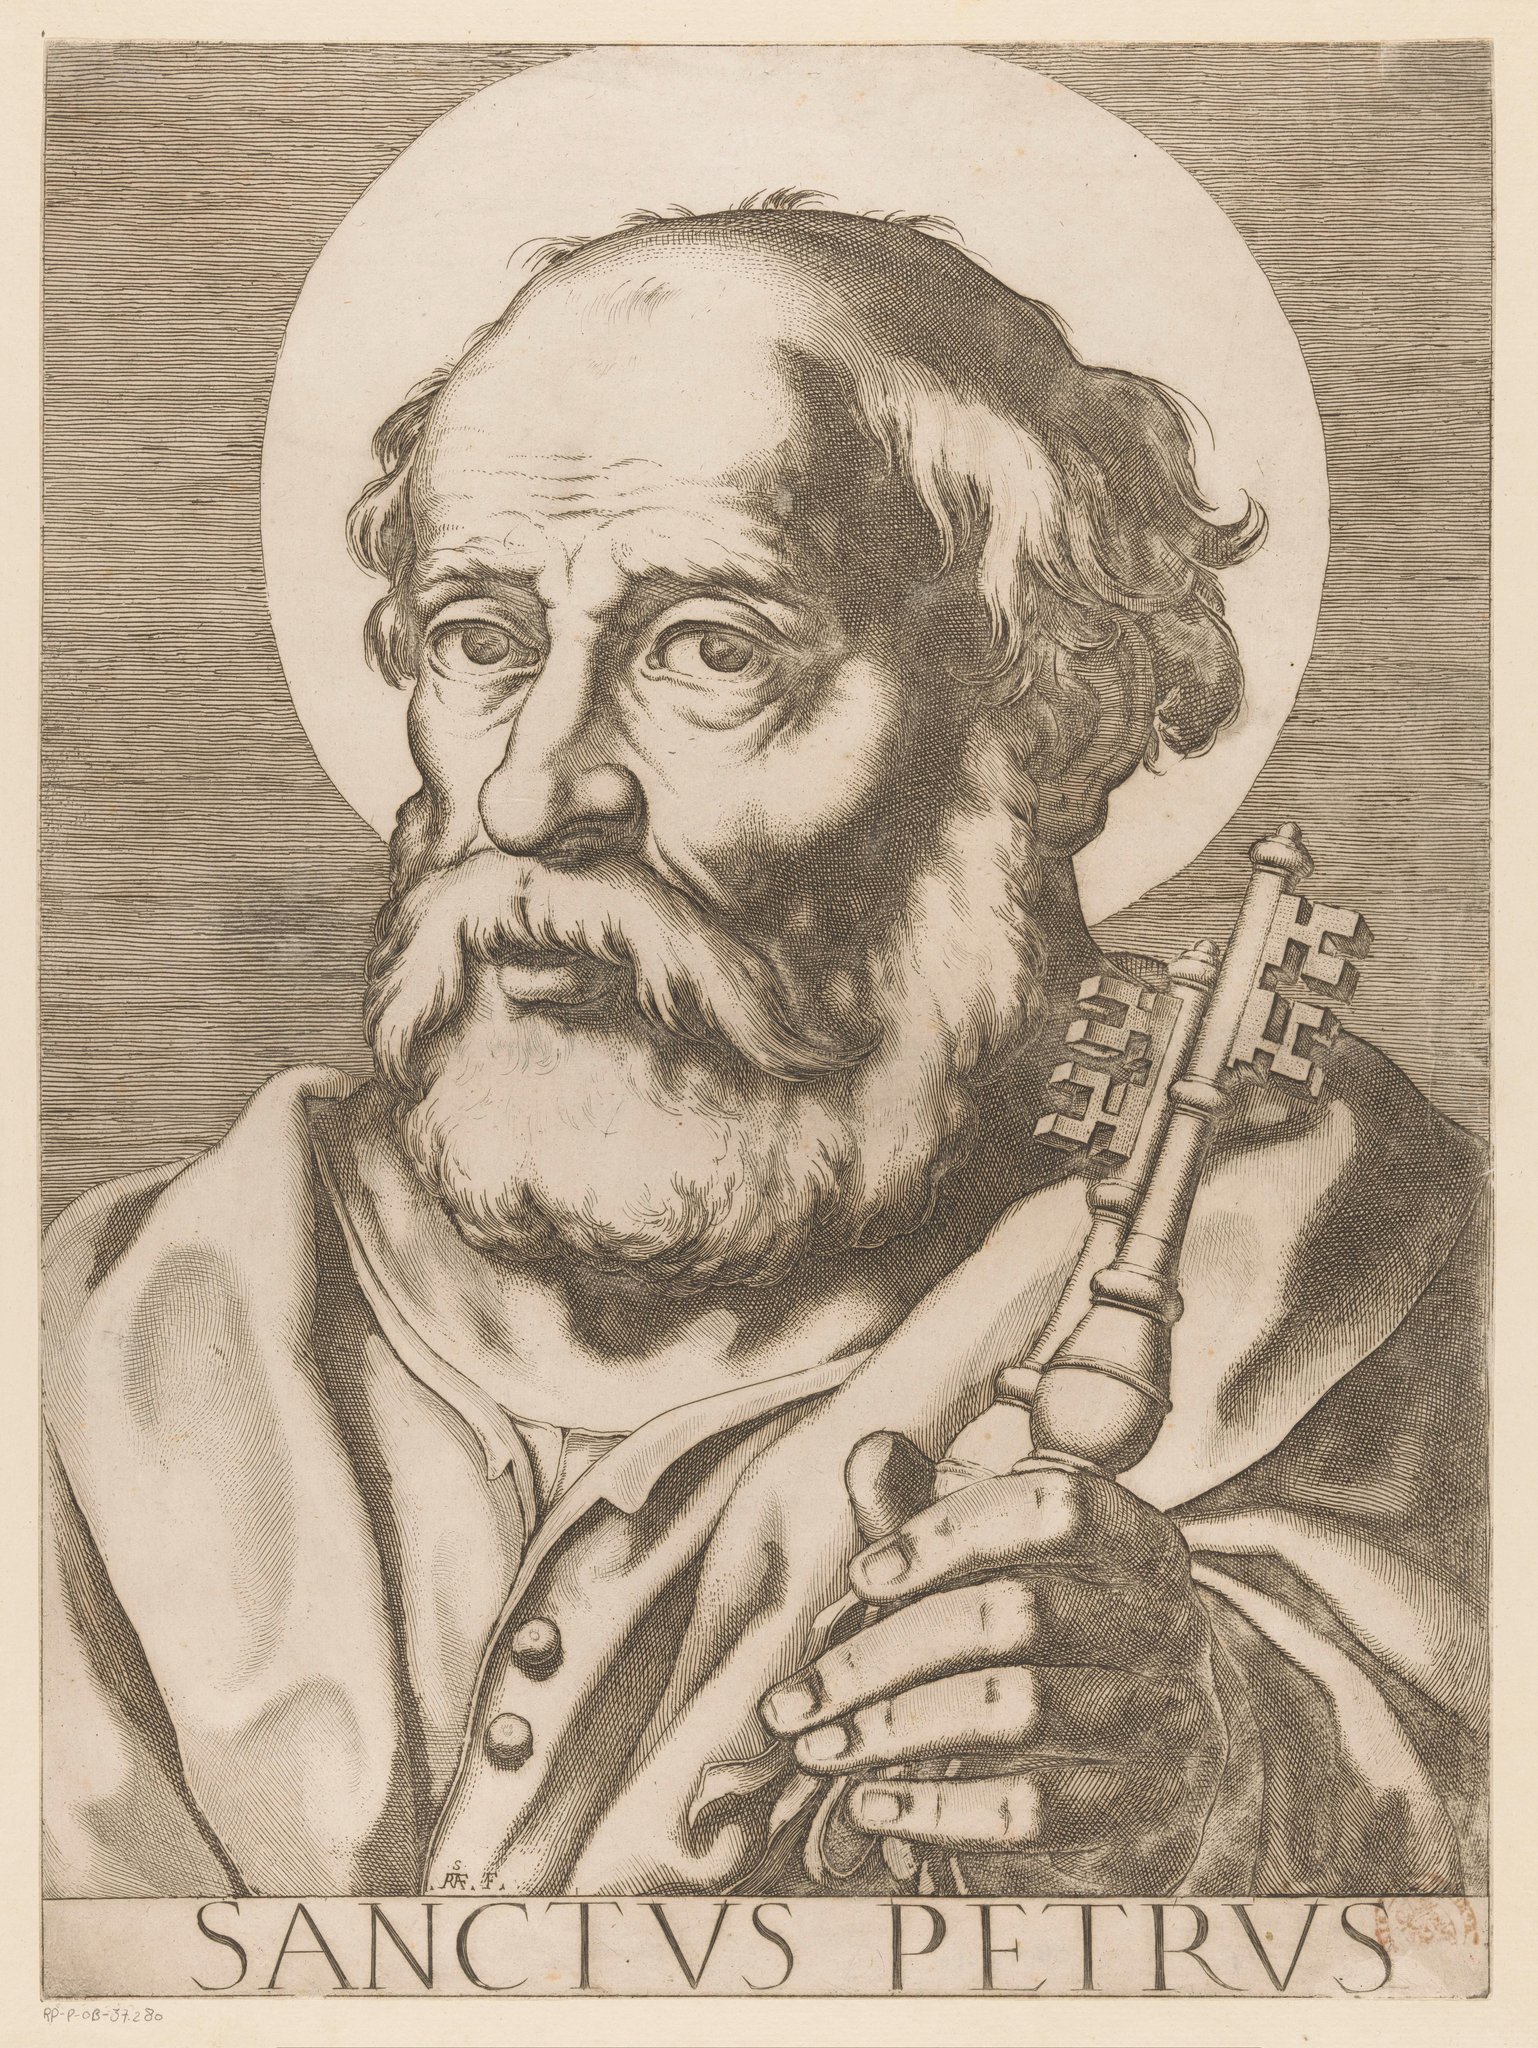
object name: print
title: Il sacrato collegio apostolico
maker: raffaello schiaminossi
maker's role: painter, print maker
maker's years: 1572-1622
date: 1606-1607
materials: paper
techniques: etching, intaglio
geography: italy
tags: the apostle peter, first bishop of rome; possible attributes: book, cock, (upturned) cross, (triple) crozier, fish, key, scroll, ship, tiara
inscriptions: collector's mark: Lugt 240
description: Deze prent maakt deel uit van een serie die bestaat uit een titelprent en veertien prenten met voorstellingen van Christus, Maria en de twaalf apostelen.